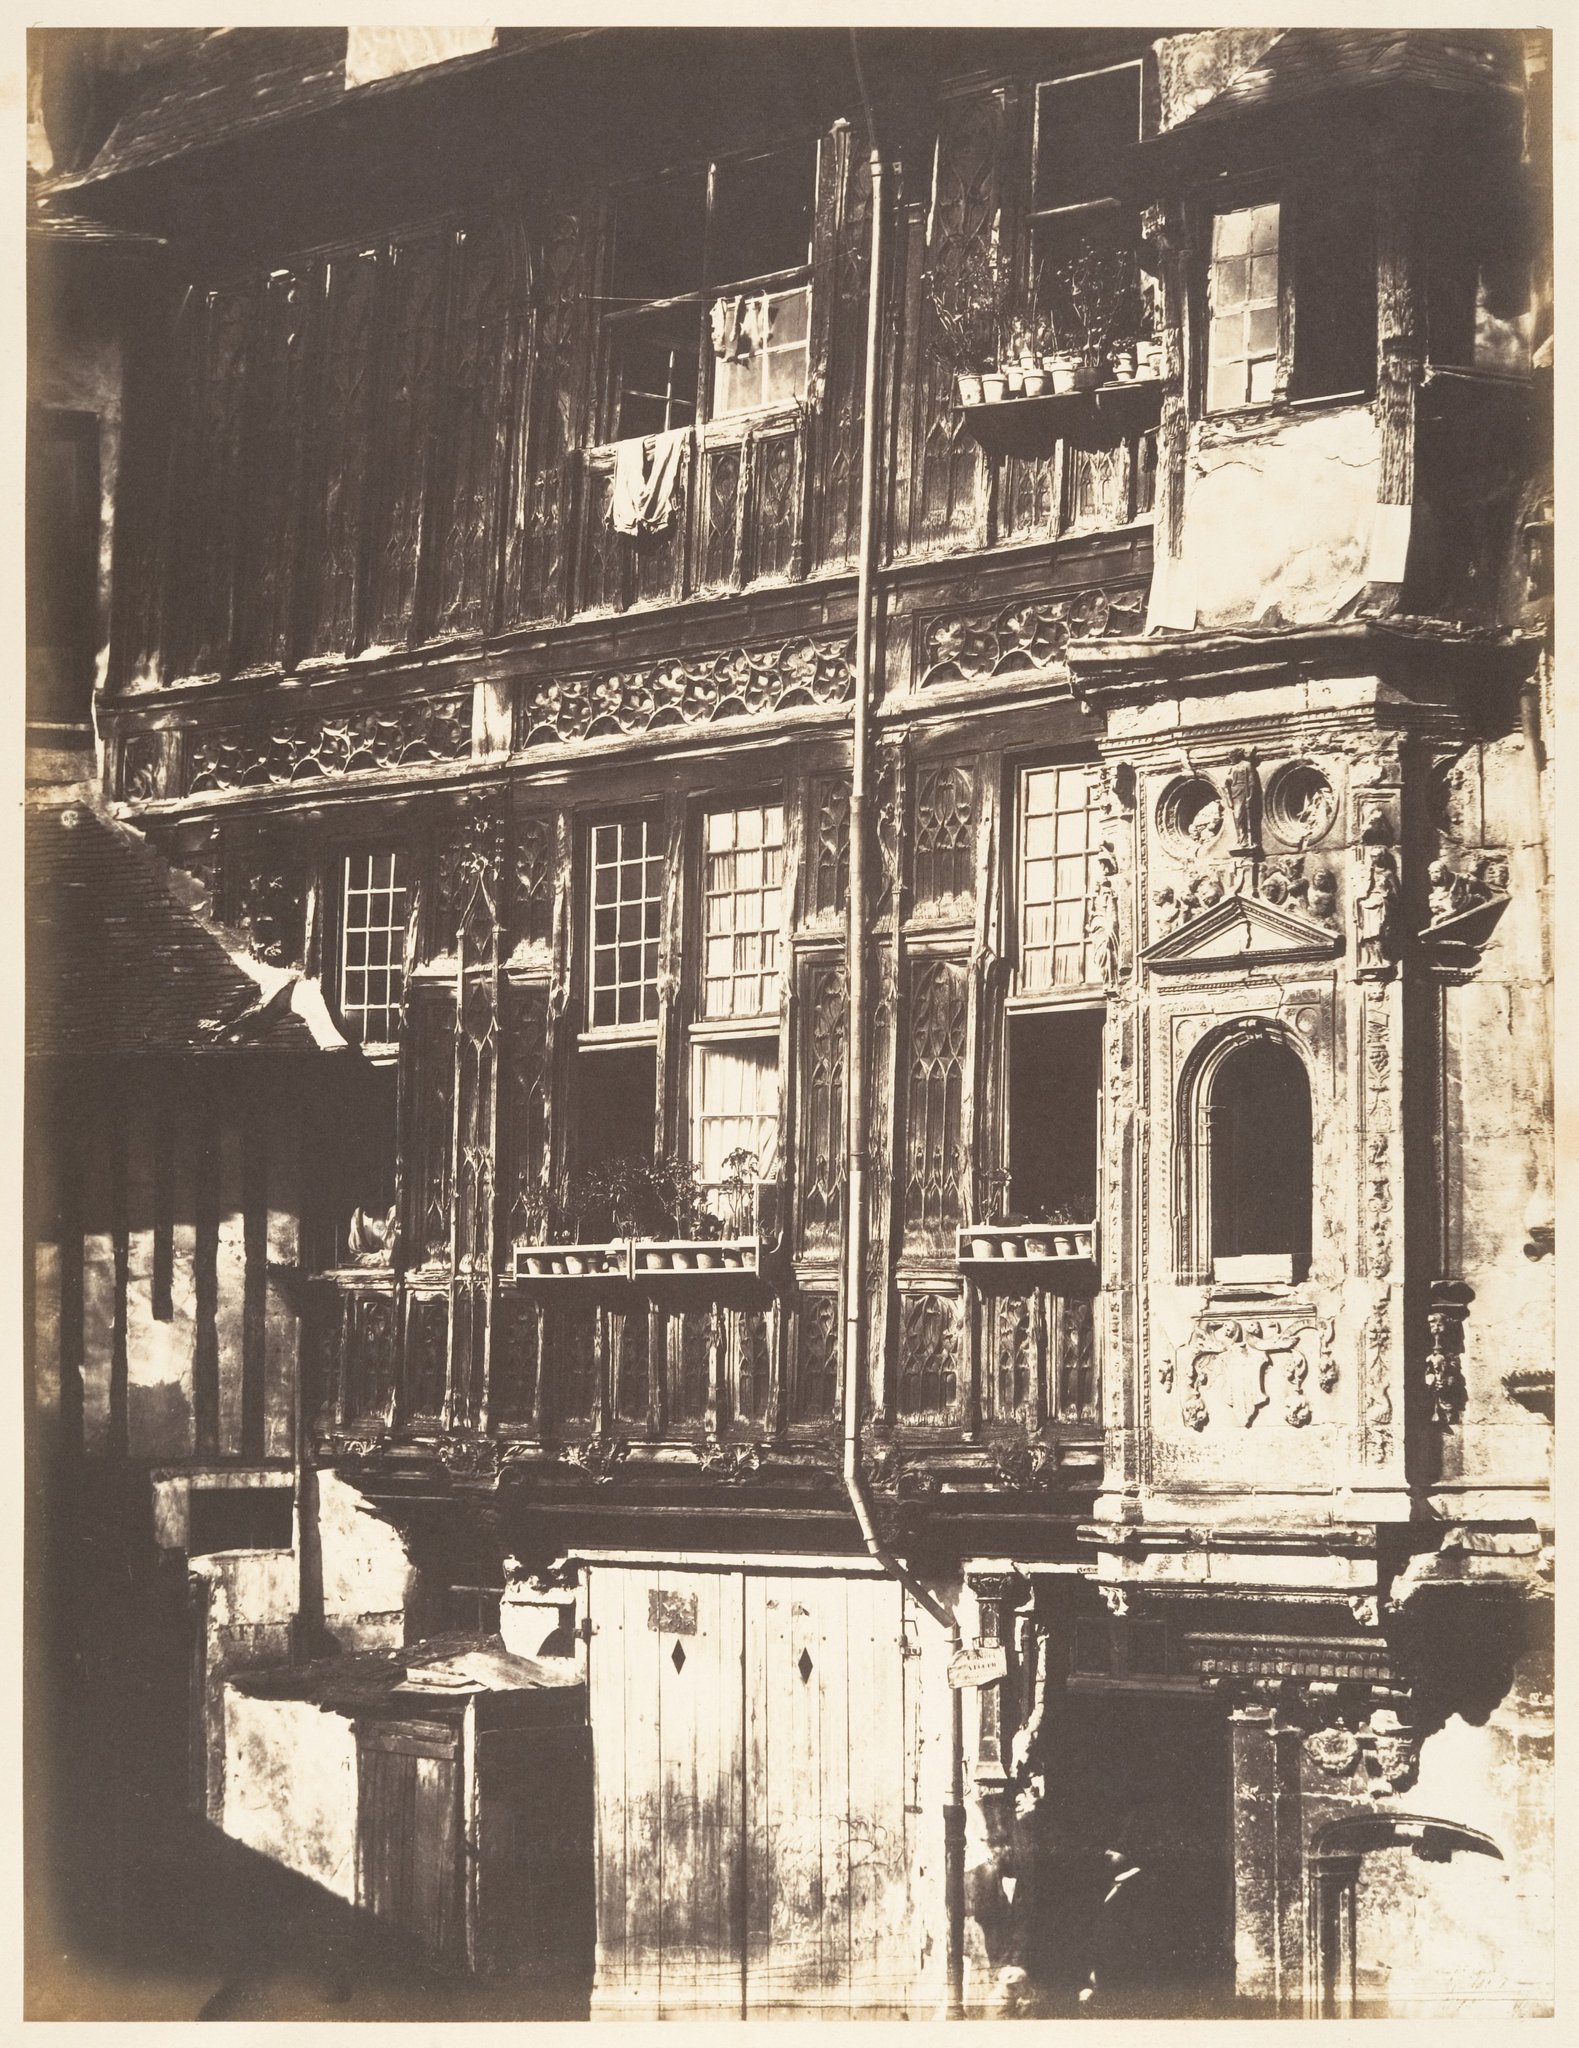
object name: photograph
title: Cloître Saint-Amand, Rouen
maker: edmond bacot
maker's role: artist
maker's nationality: french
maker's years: 1814-1875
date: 1852-1853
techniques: glass negative, salted paper print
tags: architecture,buildings